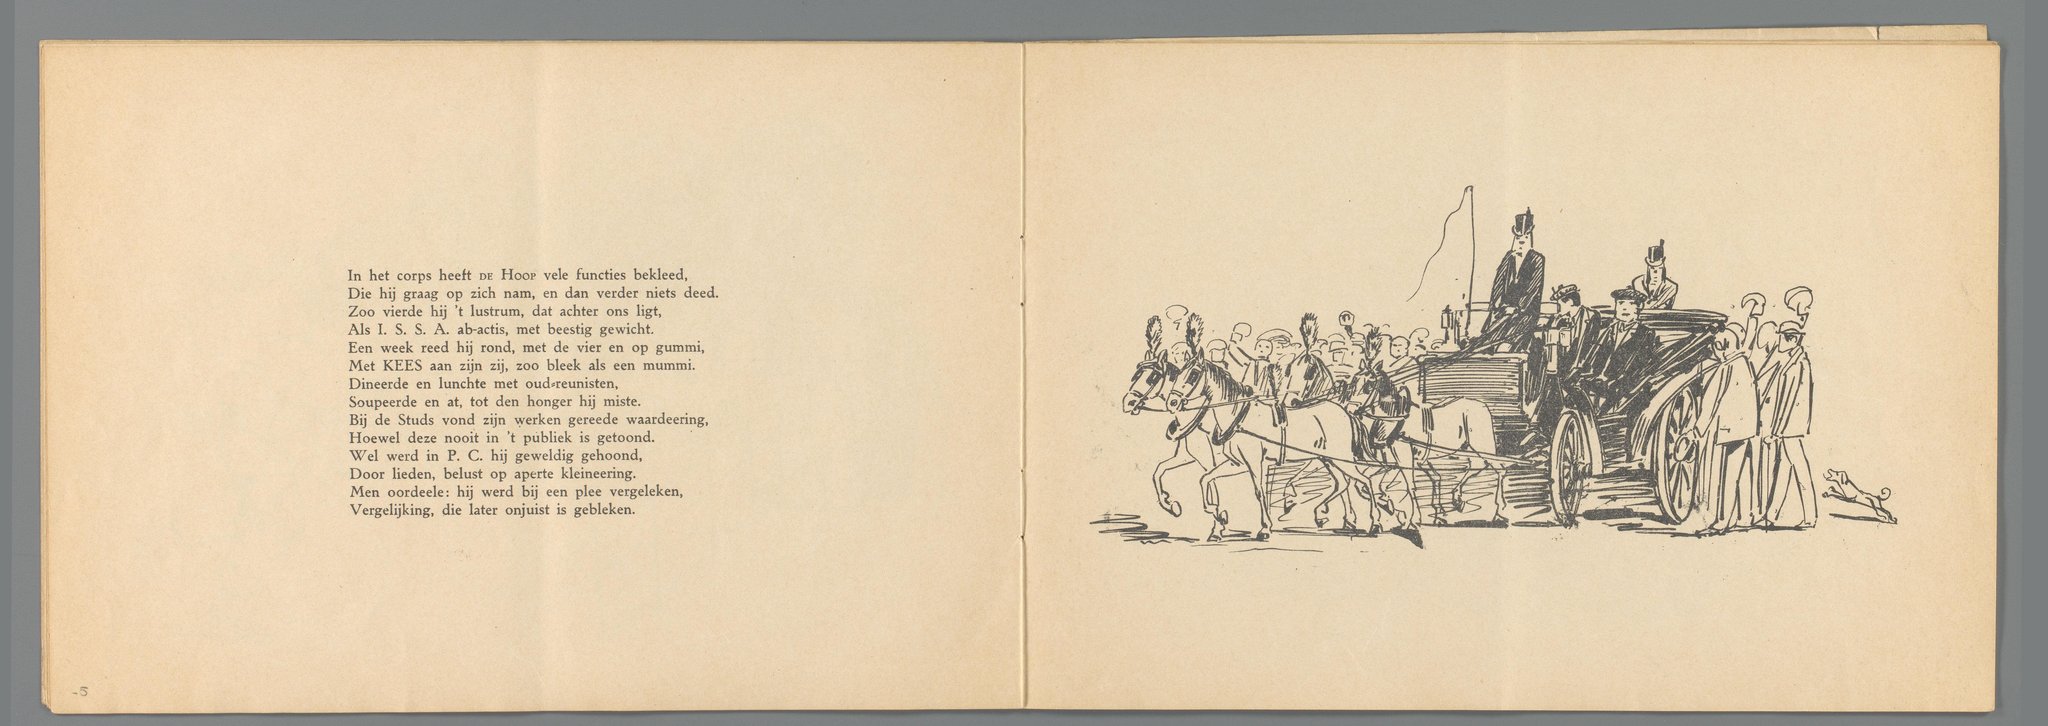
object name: print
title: Twee figuren in een koets rijdend in een menigte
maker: Anonymous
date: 1910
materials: paper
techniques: lithograph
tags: crowd, mob, four-wheeled vehicle drawn by more than three animals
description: De koets wordt door vier paarden getrokken. Op de koets tevens twee koetsiers. Op de linkerbladzijde een gedicht dat slaat op deze prent. Deze prent maakt deel uit van een album.